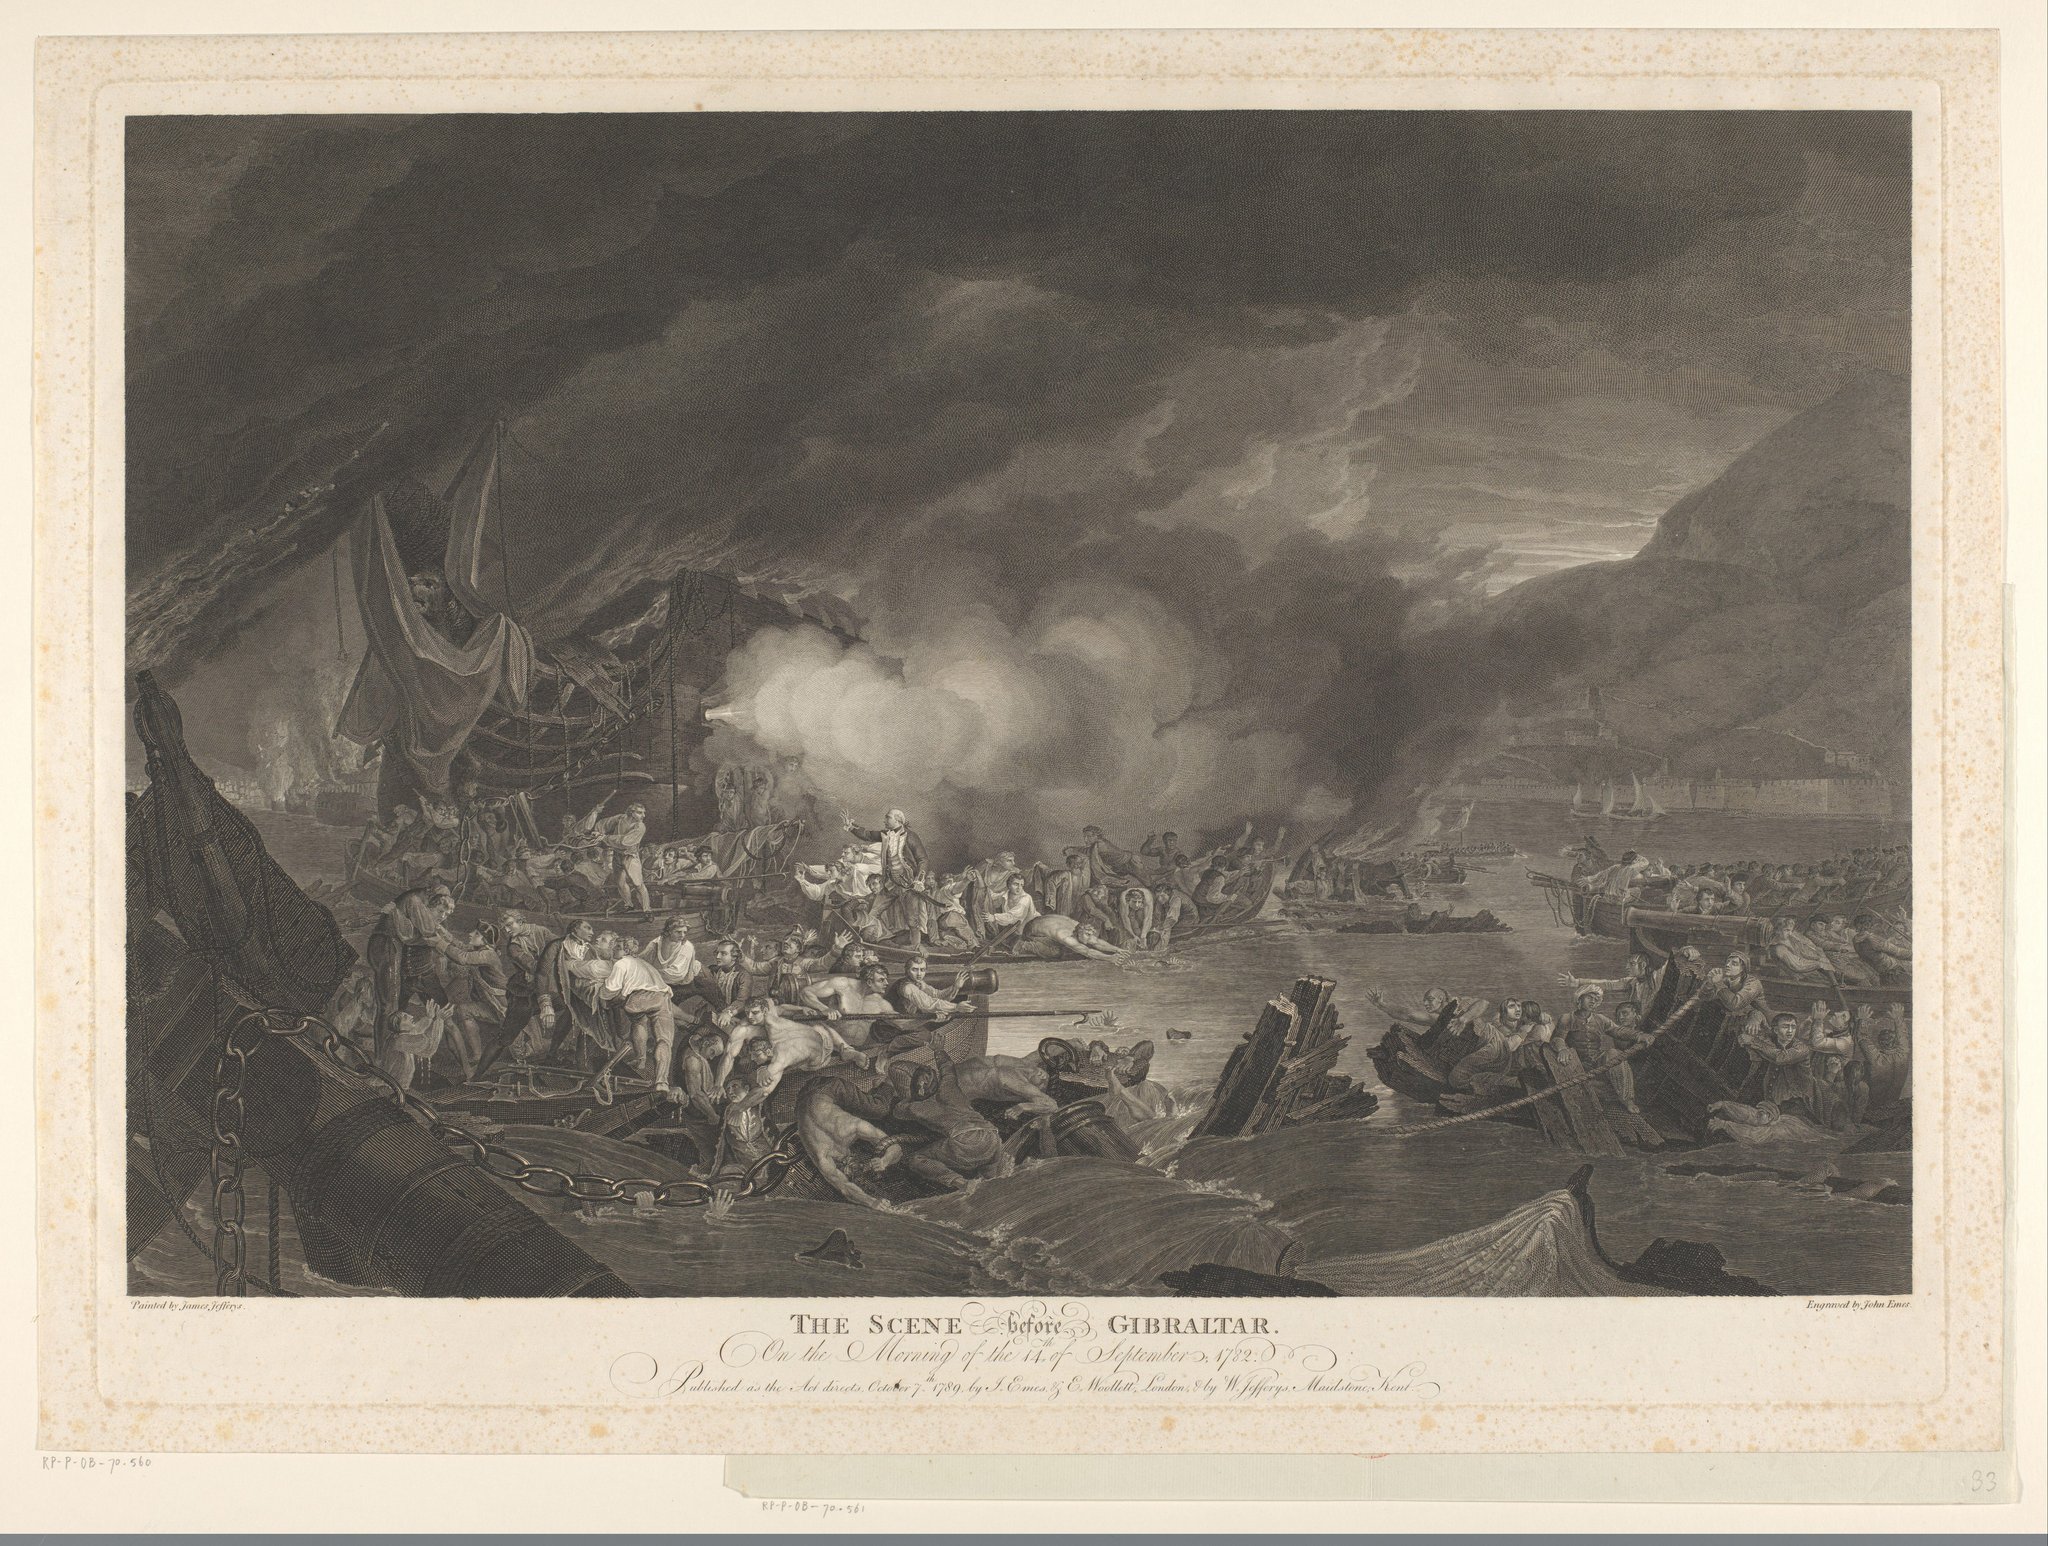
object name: print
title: The Scene before Gibraltar on the morning of the 14th of September 1782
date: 1710-1789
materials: paper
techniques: engraving, etching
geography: maidstone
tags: battle (+ naval force), drowning, shipwrecked person, shipwreck, siege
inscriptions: collector's mark: Lugt 12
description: De prent werd in 1786 door John Emes gemaakt en in 1789 uitgegeven. Bij de prent zit een tekstblad met uitleg.